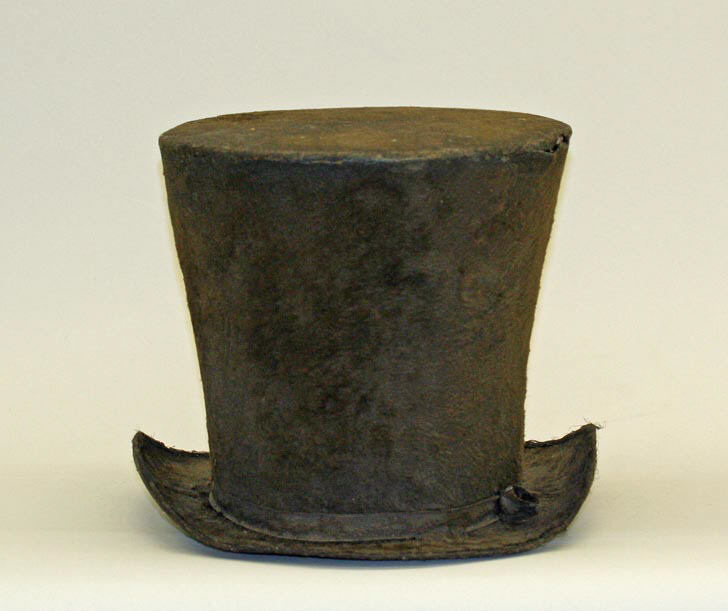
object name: hat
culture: american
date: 1829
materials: wool